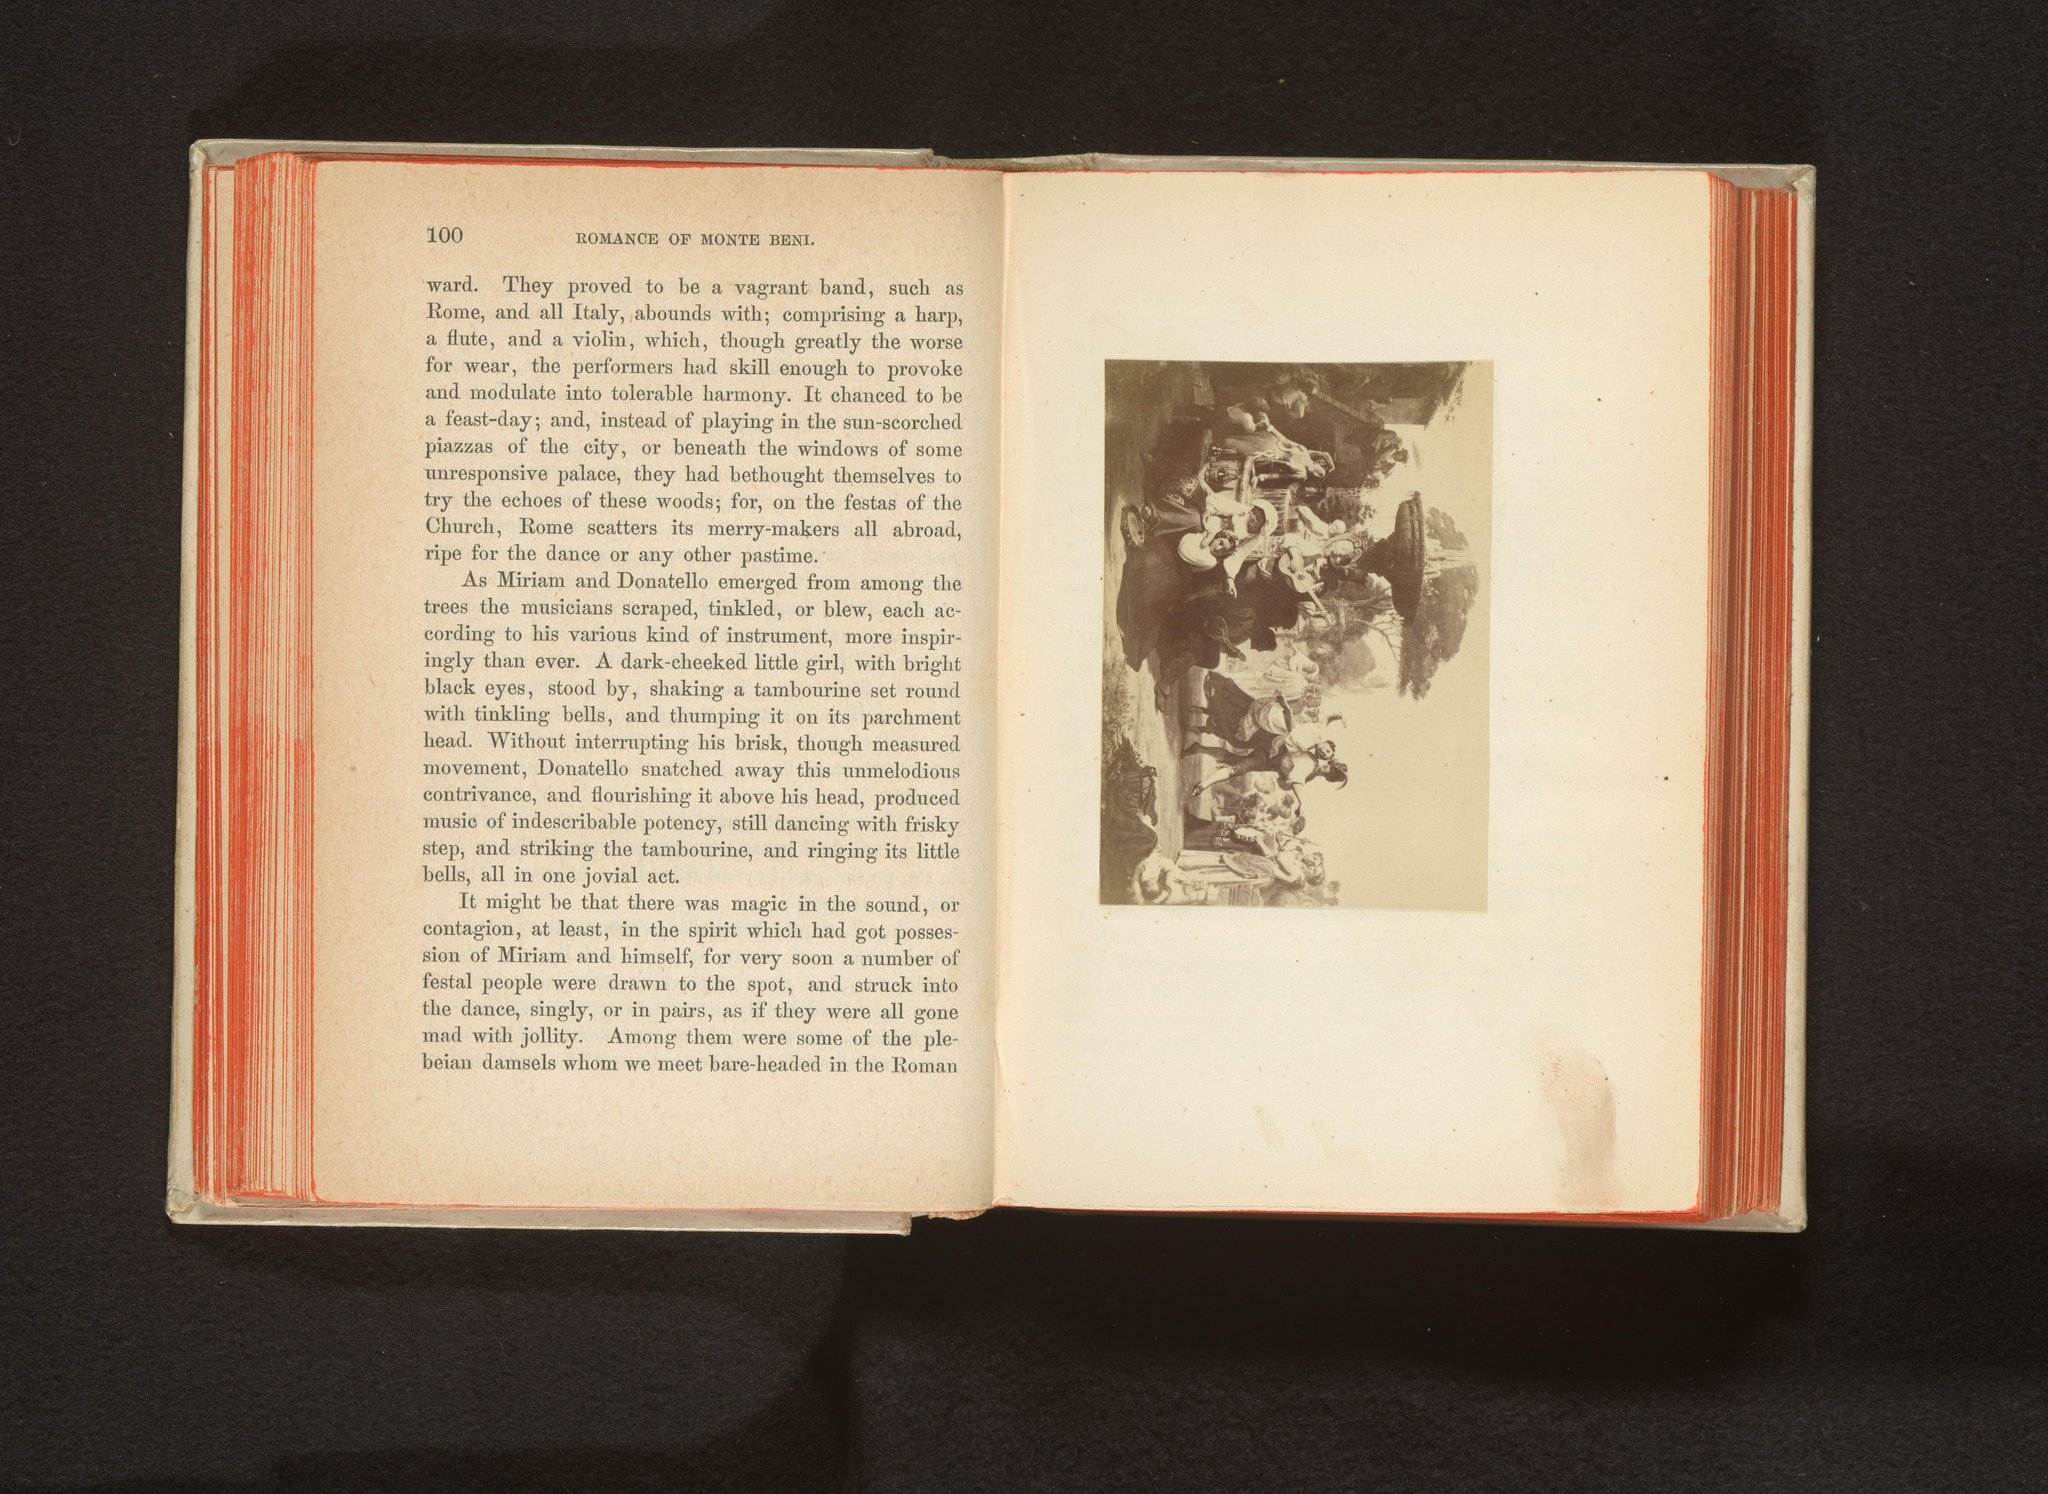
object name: page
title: Fotoreproductie van een tekening van mensen die dansen in de tuin van Villa Borghese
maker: Anonymous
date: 1850-1860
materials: photographic support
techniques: albumen print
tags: folk dancing (men and women together)